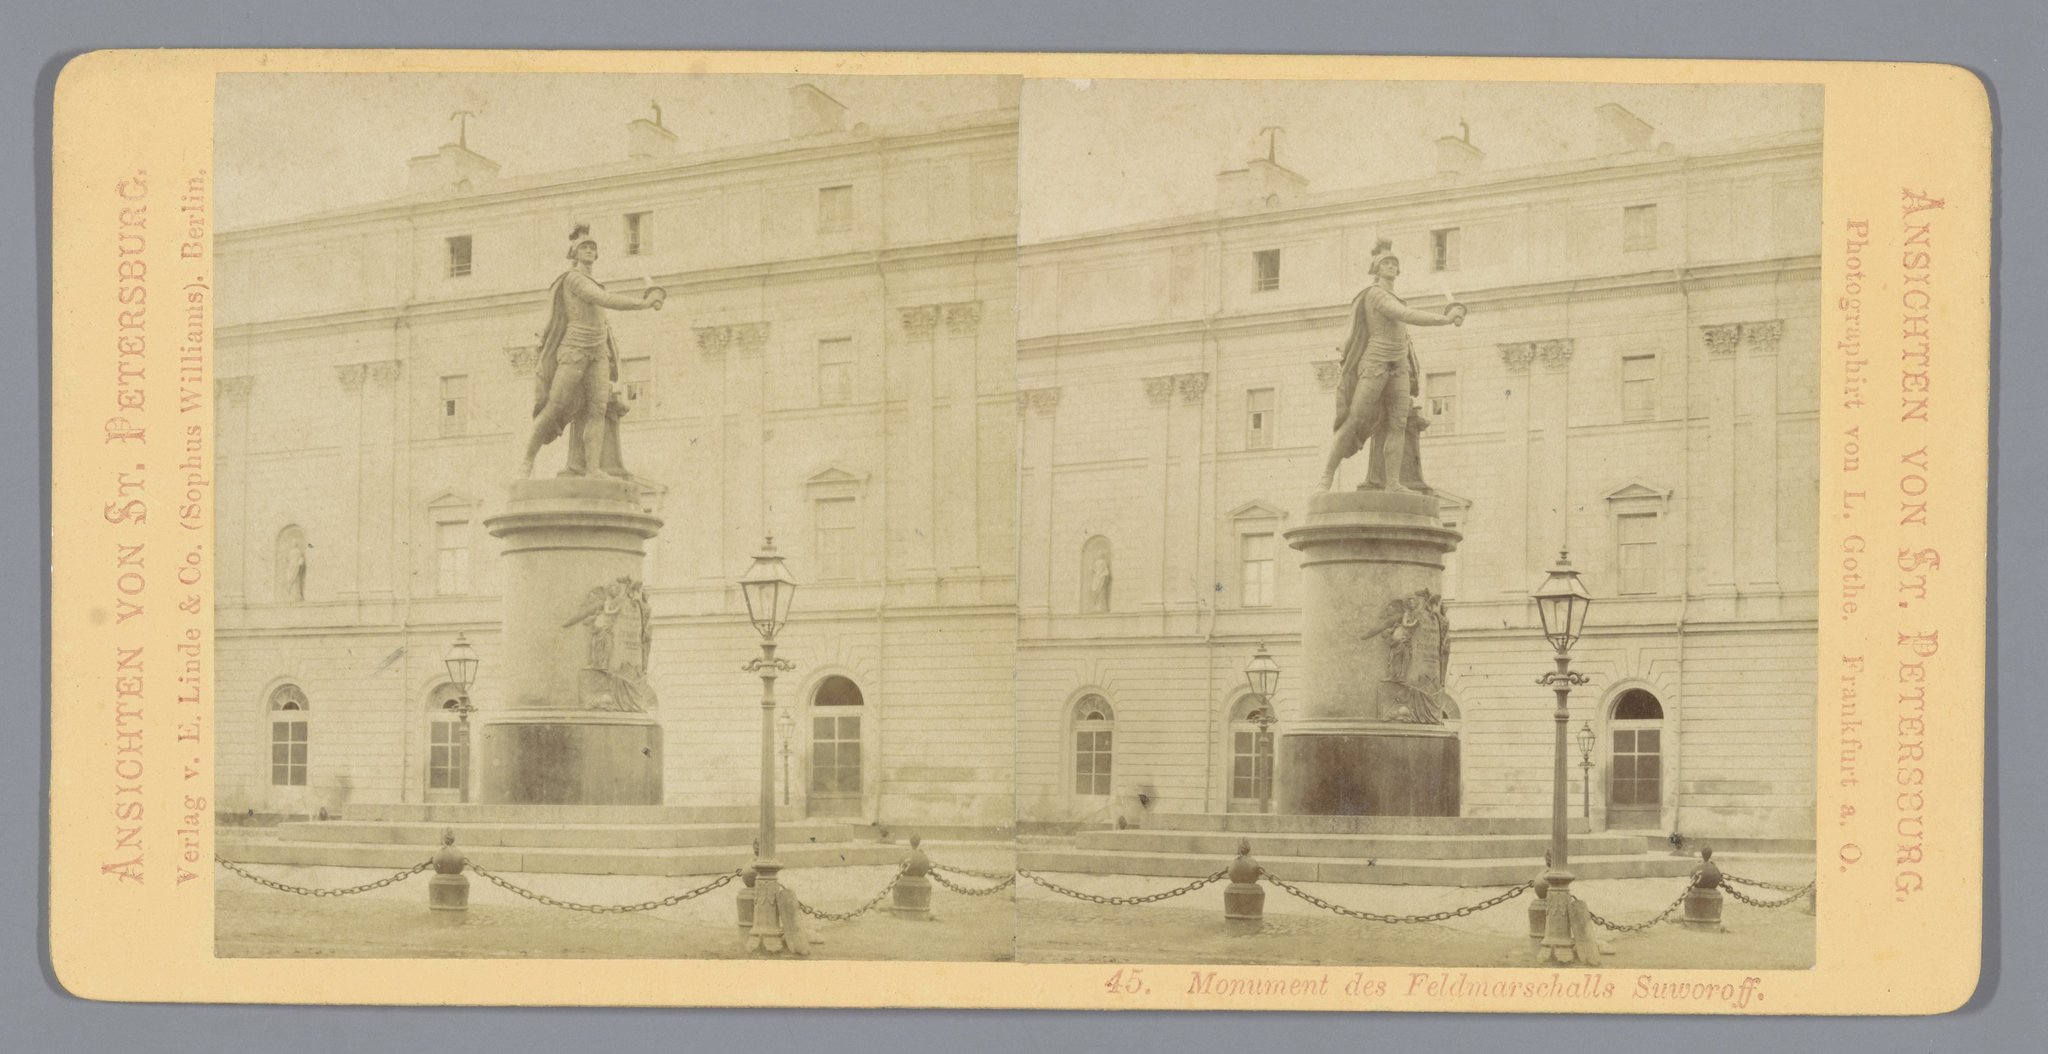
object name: stereograph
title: Monument voor generaal Aleksandr Soevorov in Sint-Petersburg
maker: louis gothe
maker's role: fotograaf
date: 1850-1880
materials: cardboard, photographic support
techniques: albumen print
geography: berlin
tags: monument, statue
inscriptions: number: ‘45.’, inscription: ‘Ansichten von St. Petersburg.’